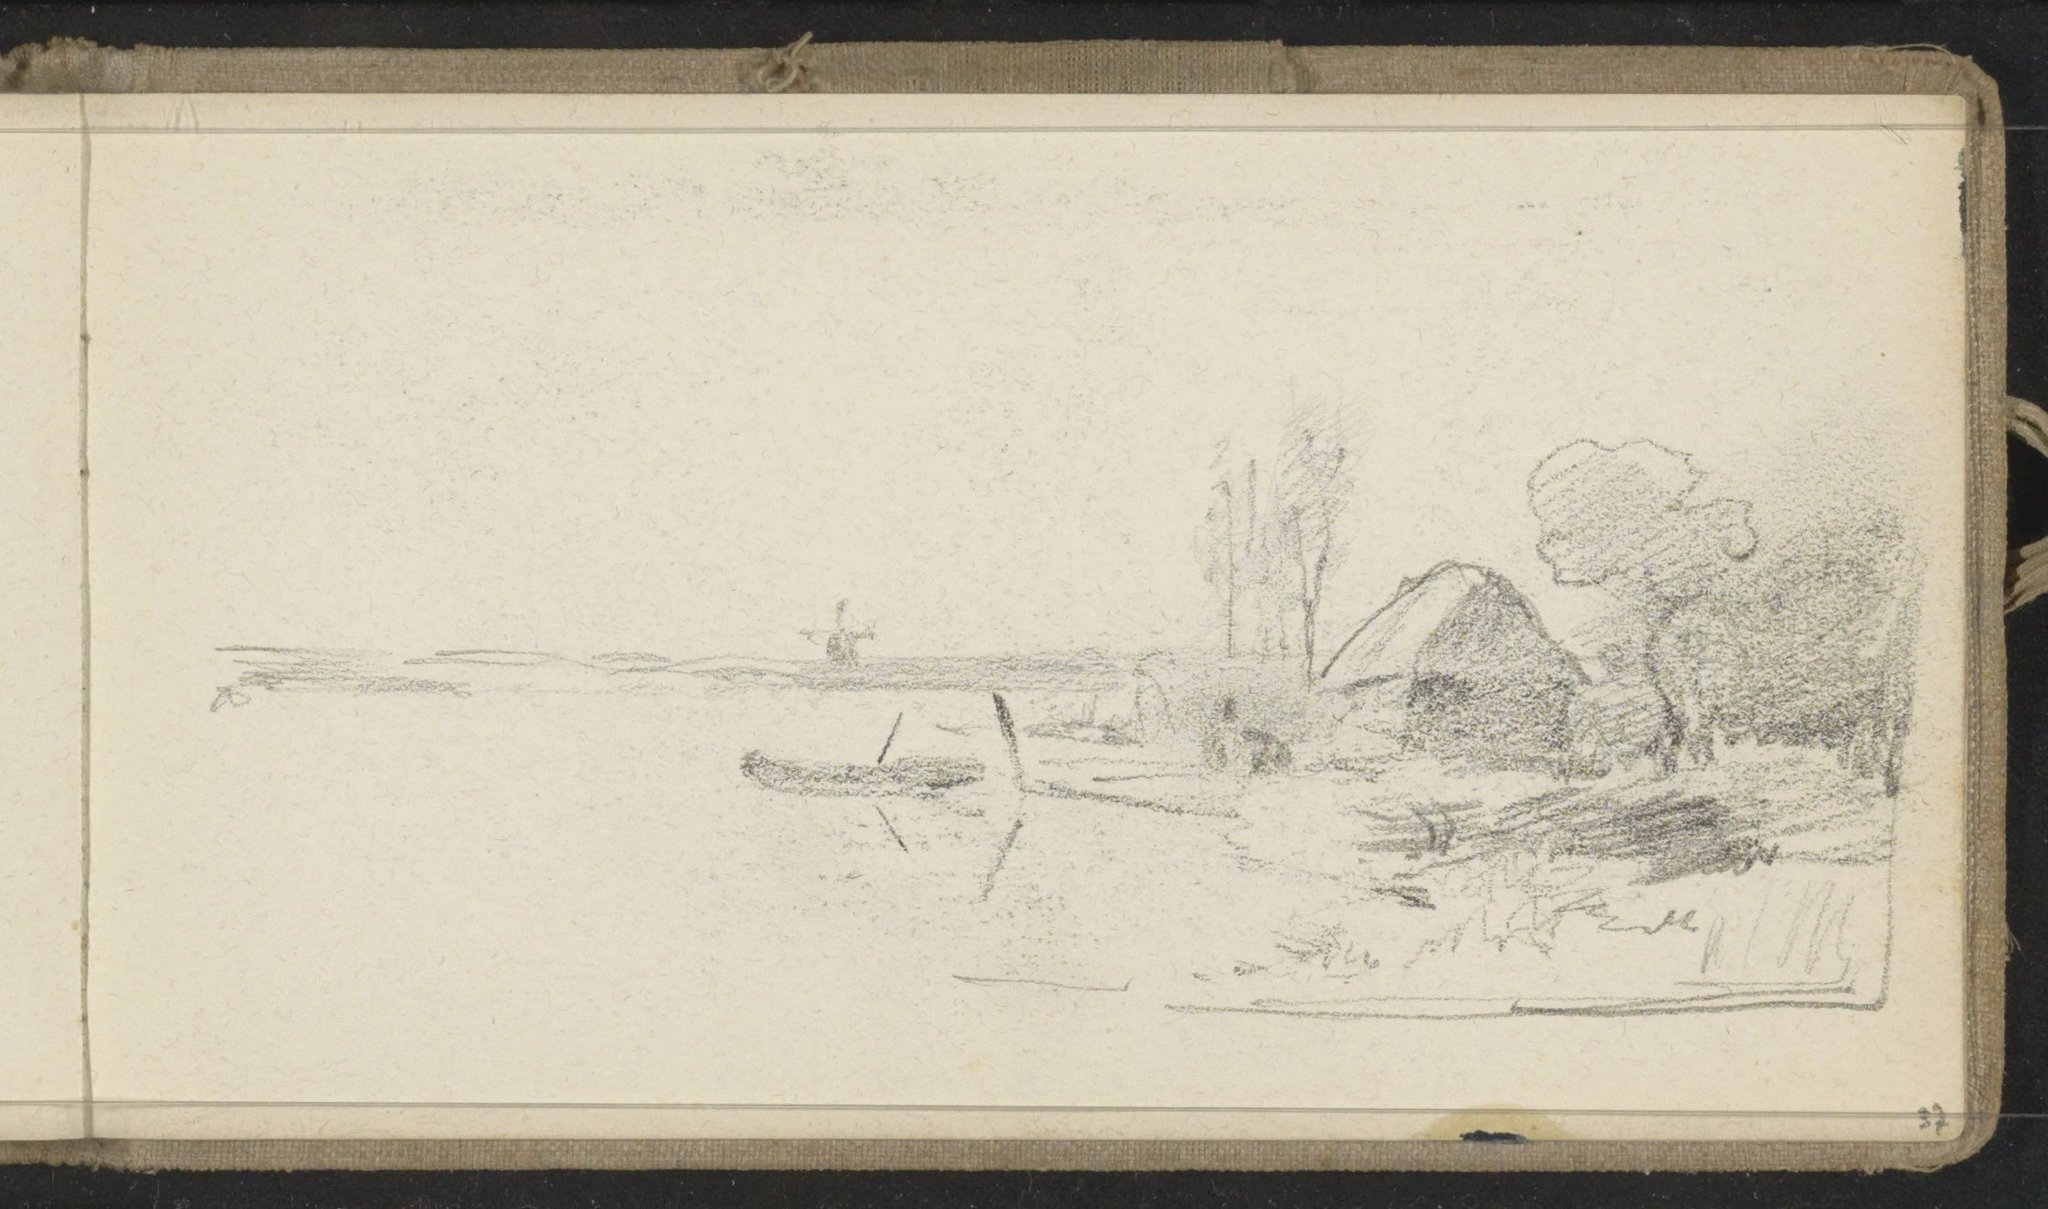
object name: sketchbook leaf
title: Boerderij aan een waterkant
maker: willem cornelis rip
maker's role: draughtsman, painter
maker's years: 1856-1922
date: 1895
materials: paper, pencil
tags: landscapes with waters, waterscapes, seascapes (in the temperate zone), village, rowing-boat, canoe, etc.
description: Op de achtergrond een molen. Blad 37 recto uit een schetsboek met 39 bladen.